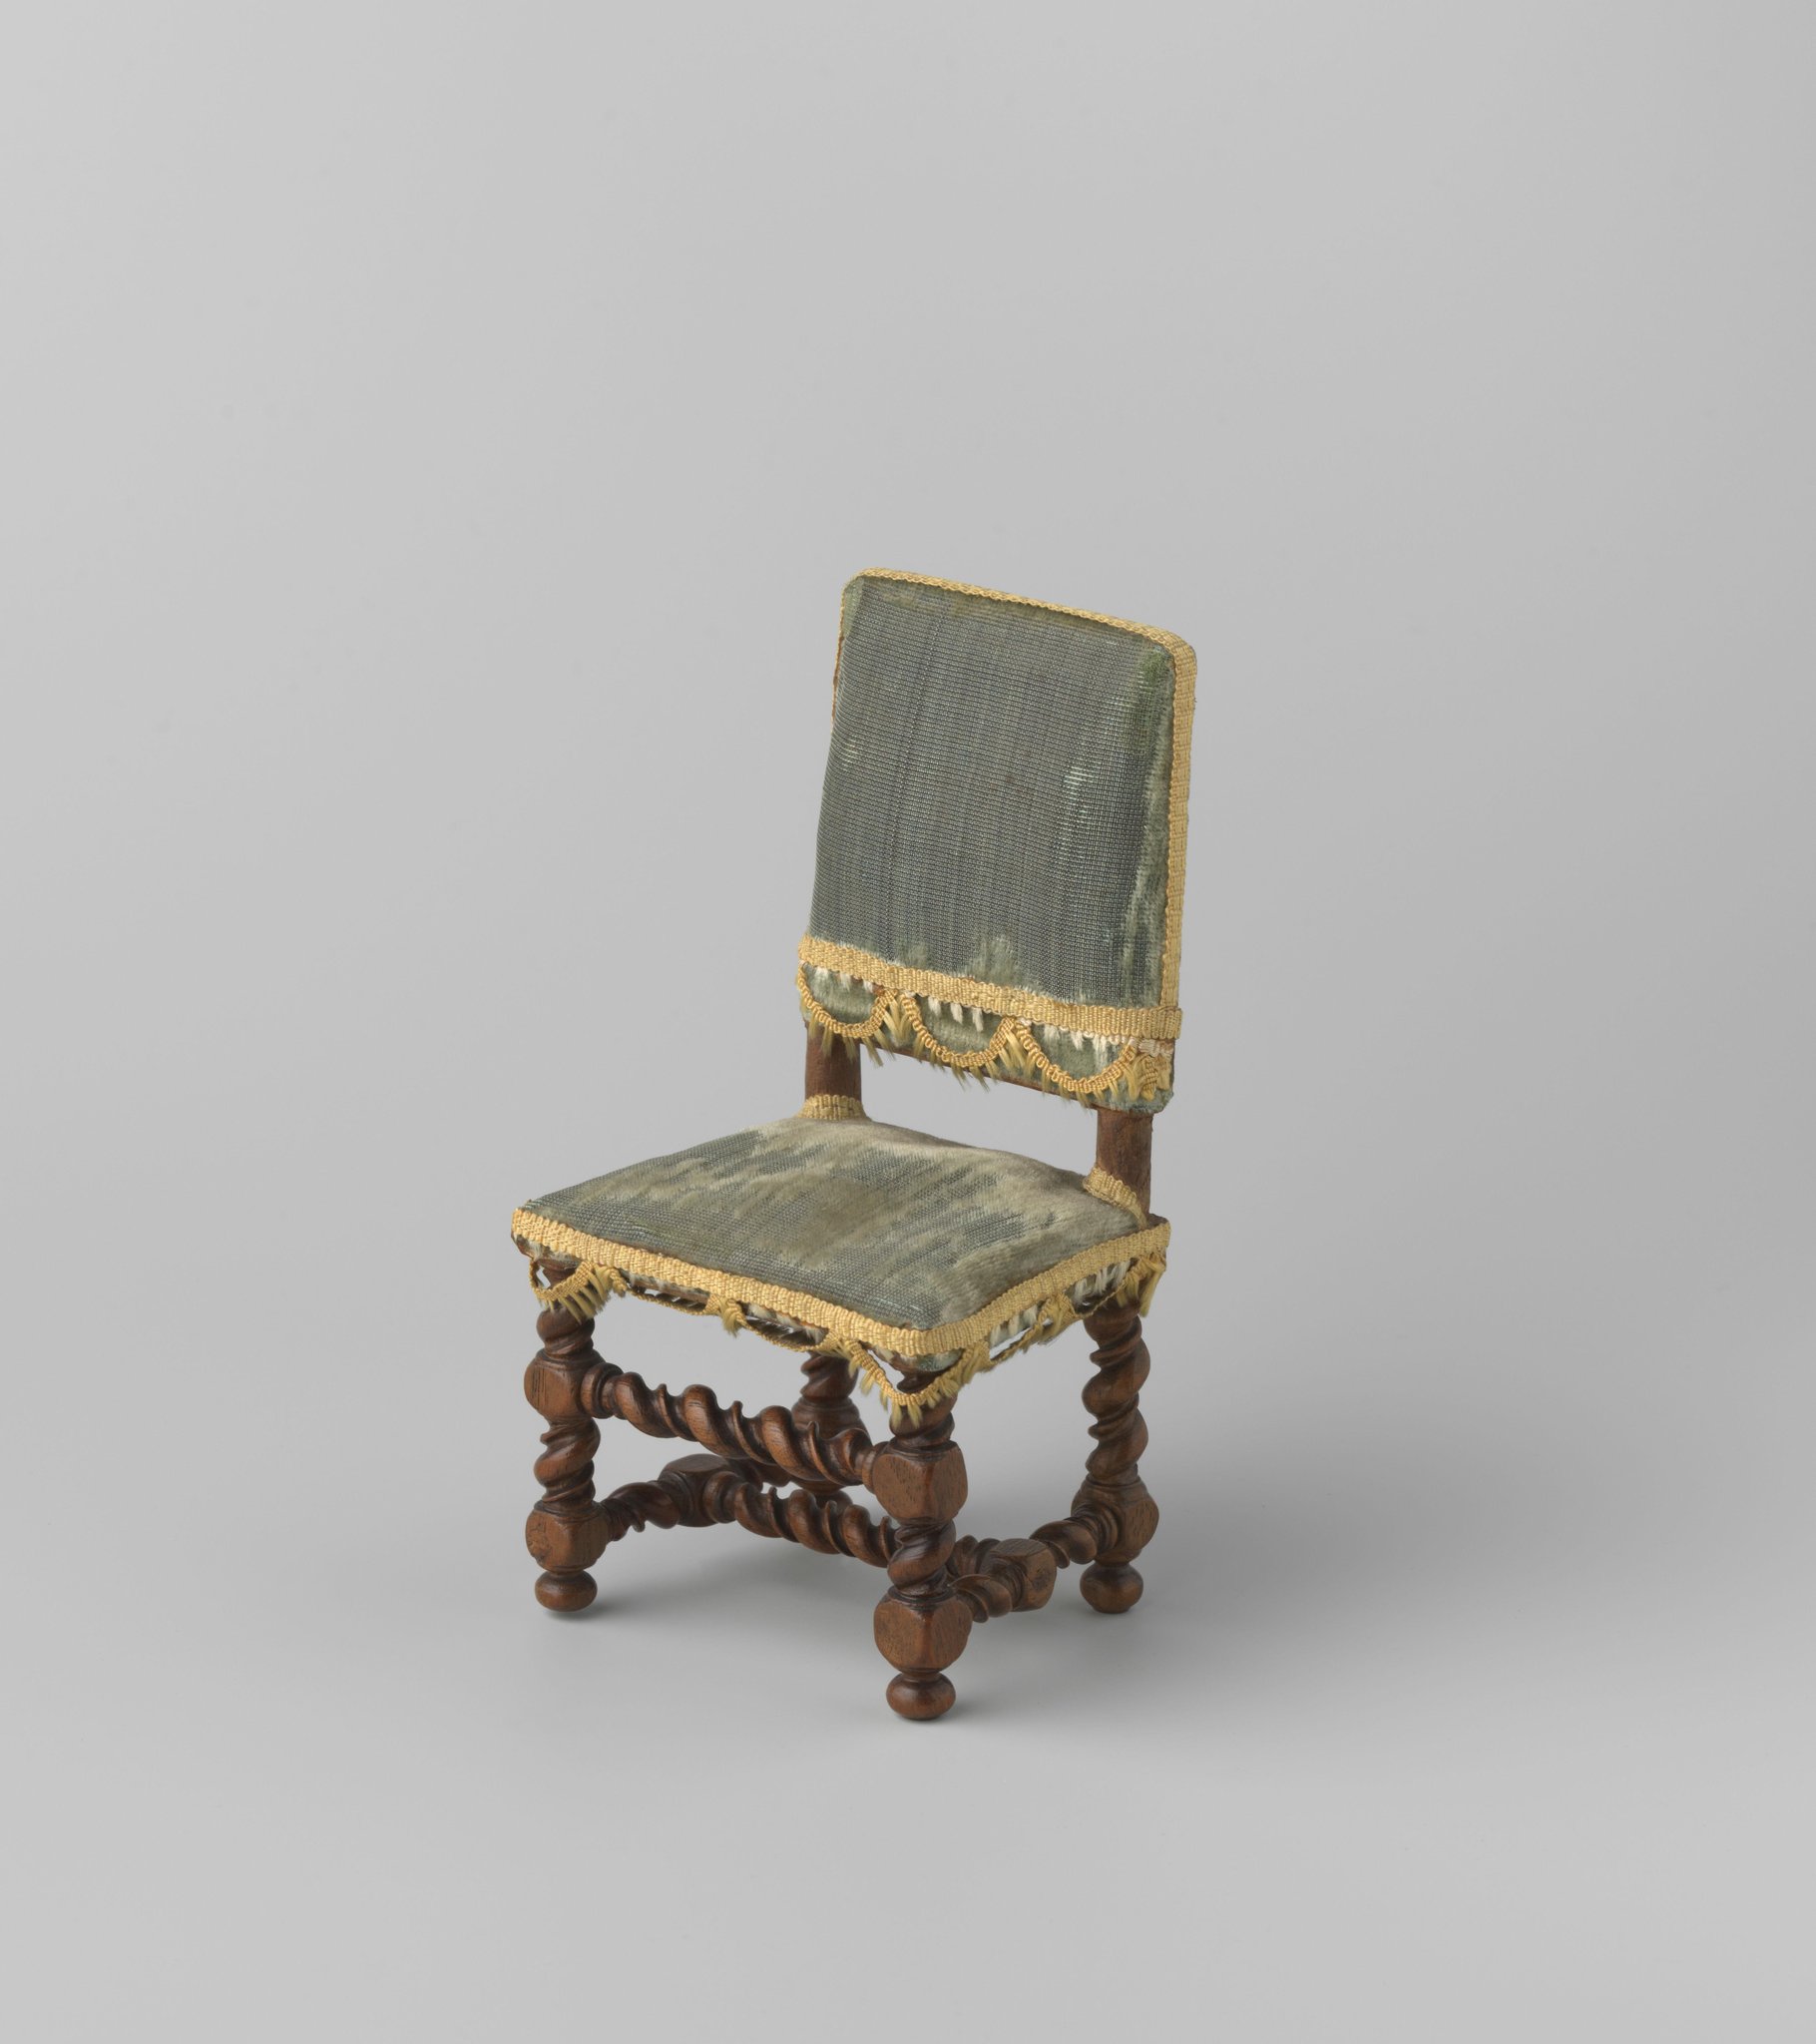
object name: miniature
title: Leunstoel vervaardigd van notenhout; stijlen, voorregel en H-vormig kruis met smalle en breede tors versierd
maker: Anonymous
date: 1690-1710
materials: linen, board, silk, wood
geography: amsterdam